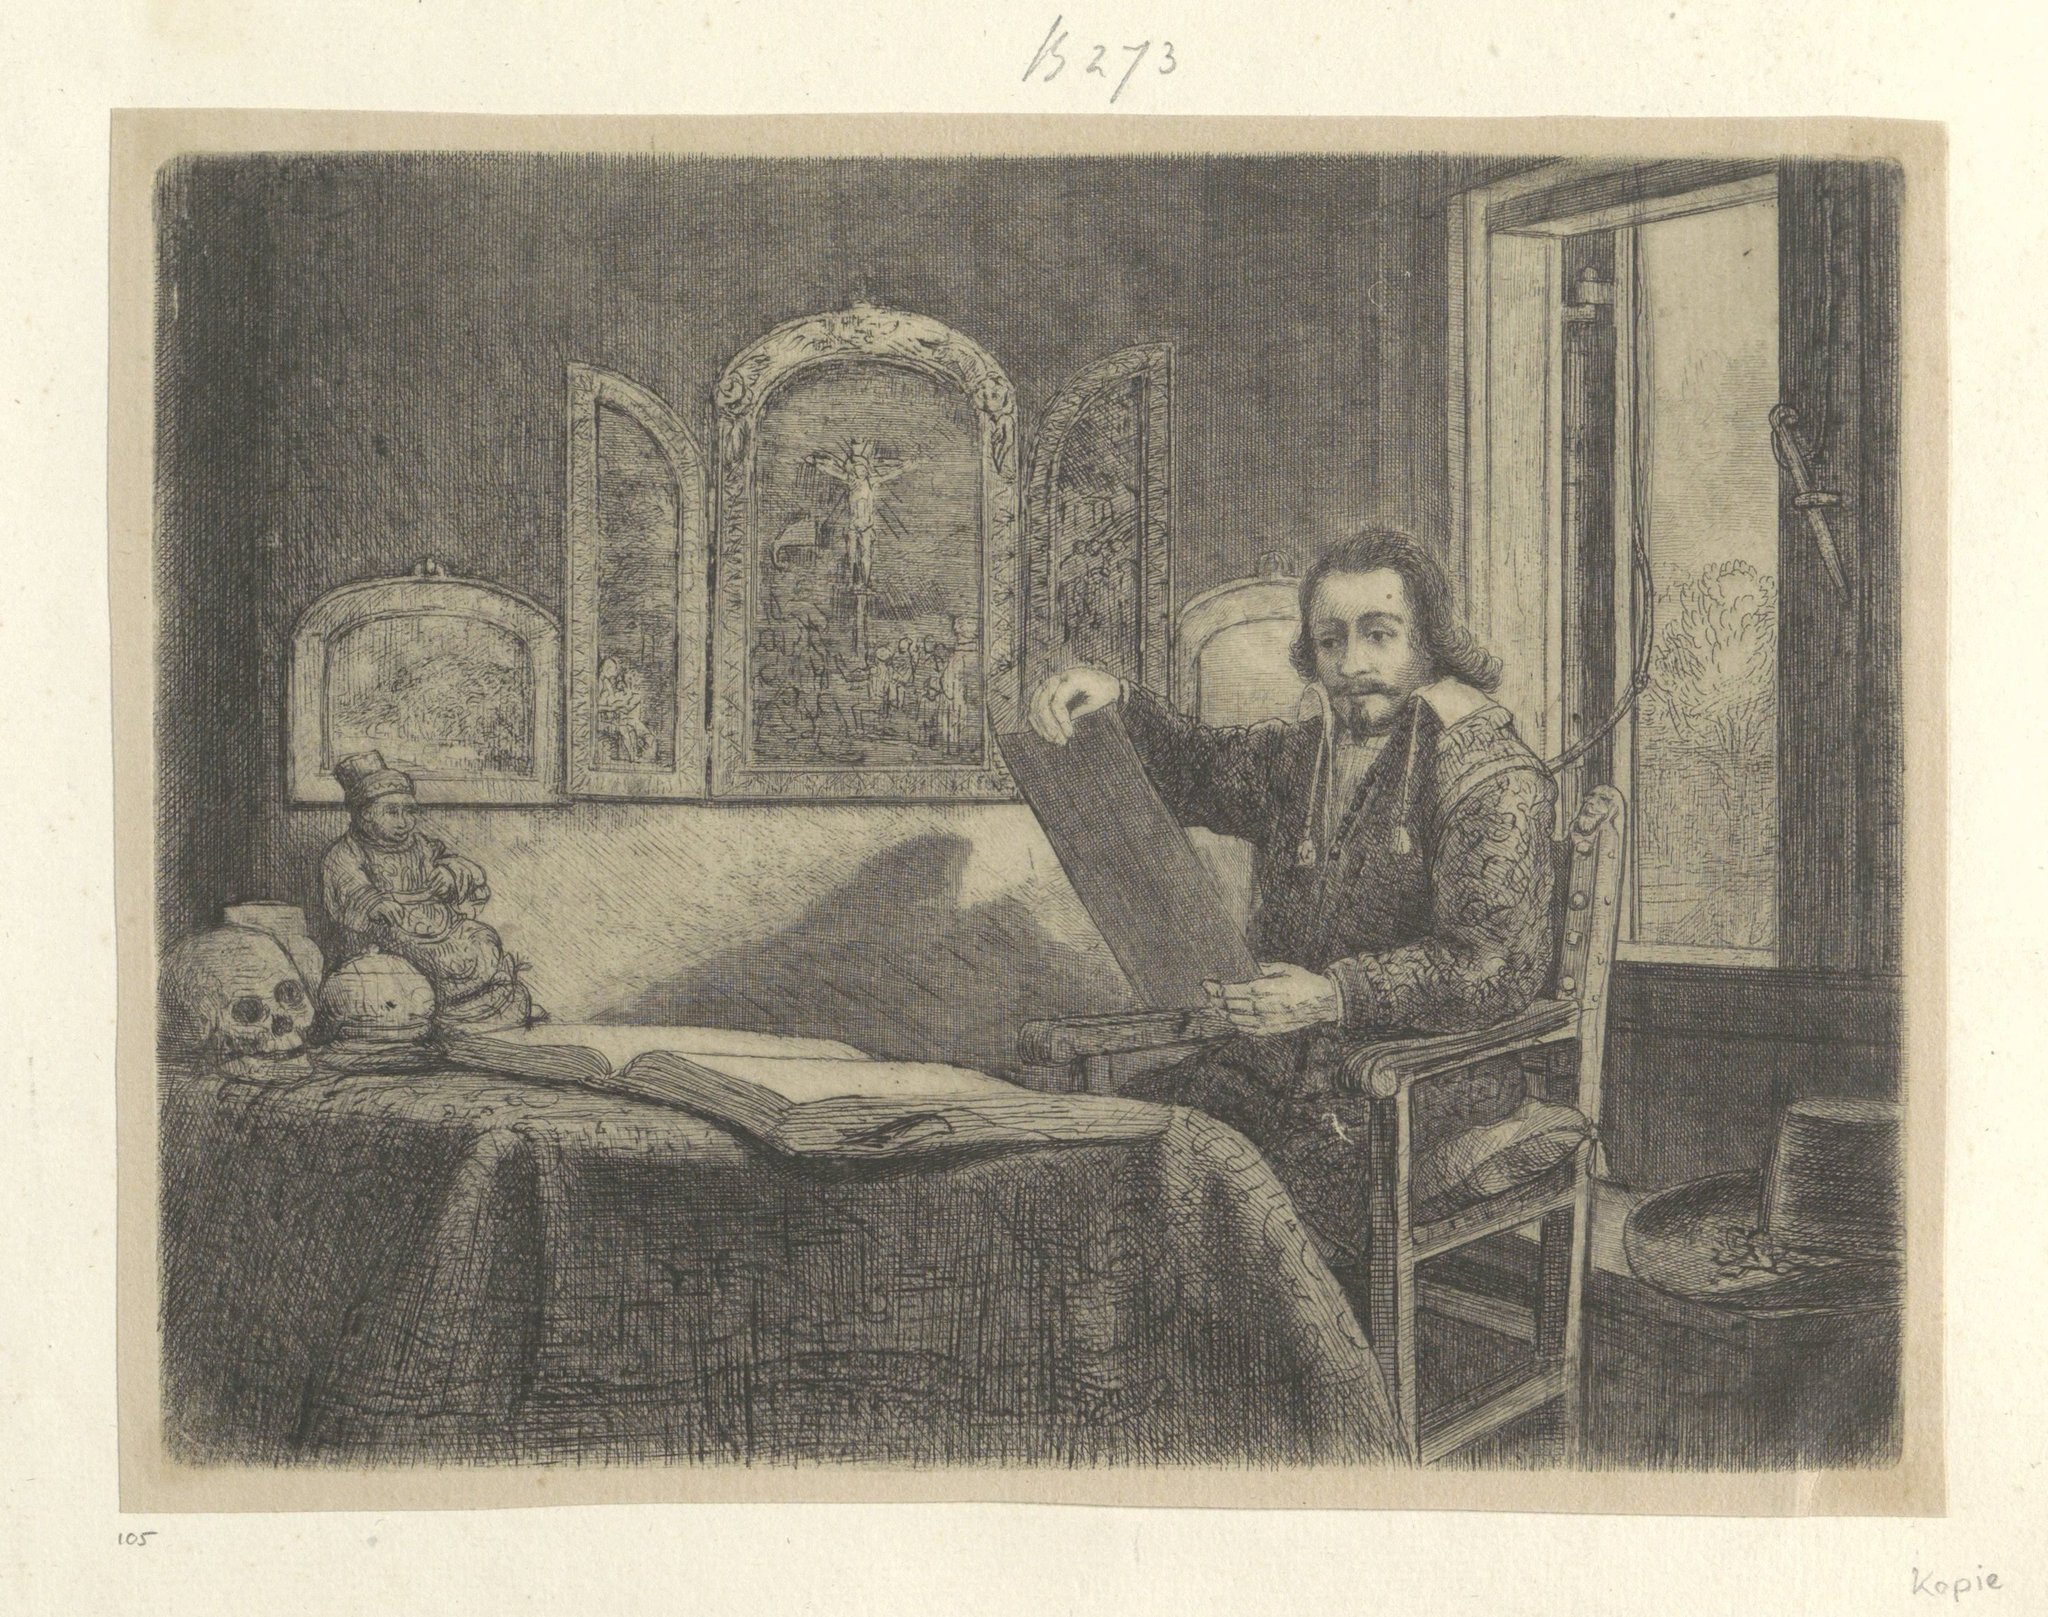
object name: album leaf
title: Recueil de quatre-vingt-cinq estampes originales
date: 1655-1807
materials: paper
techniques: drypoint, engraving, etching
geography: paris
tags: abraham francen